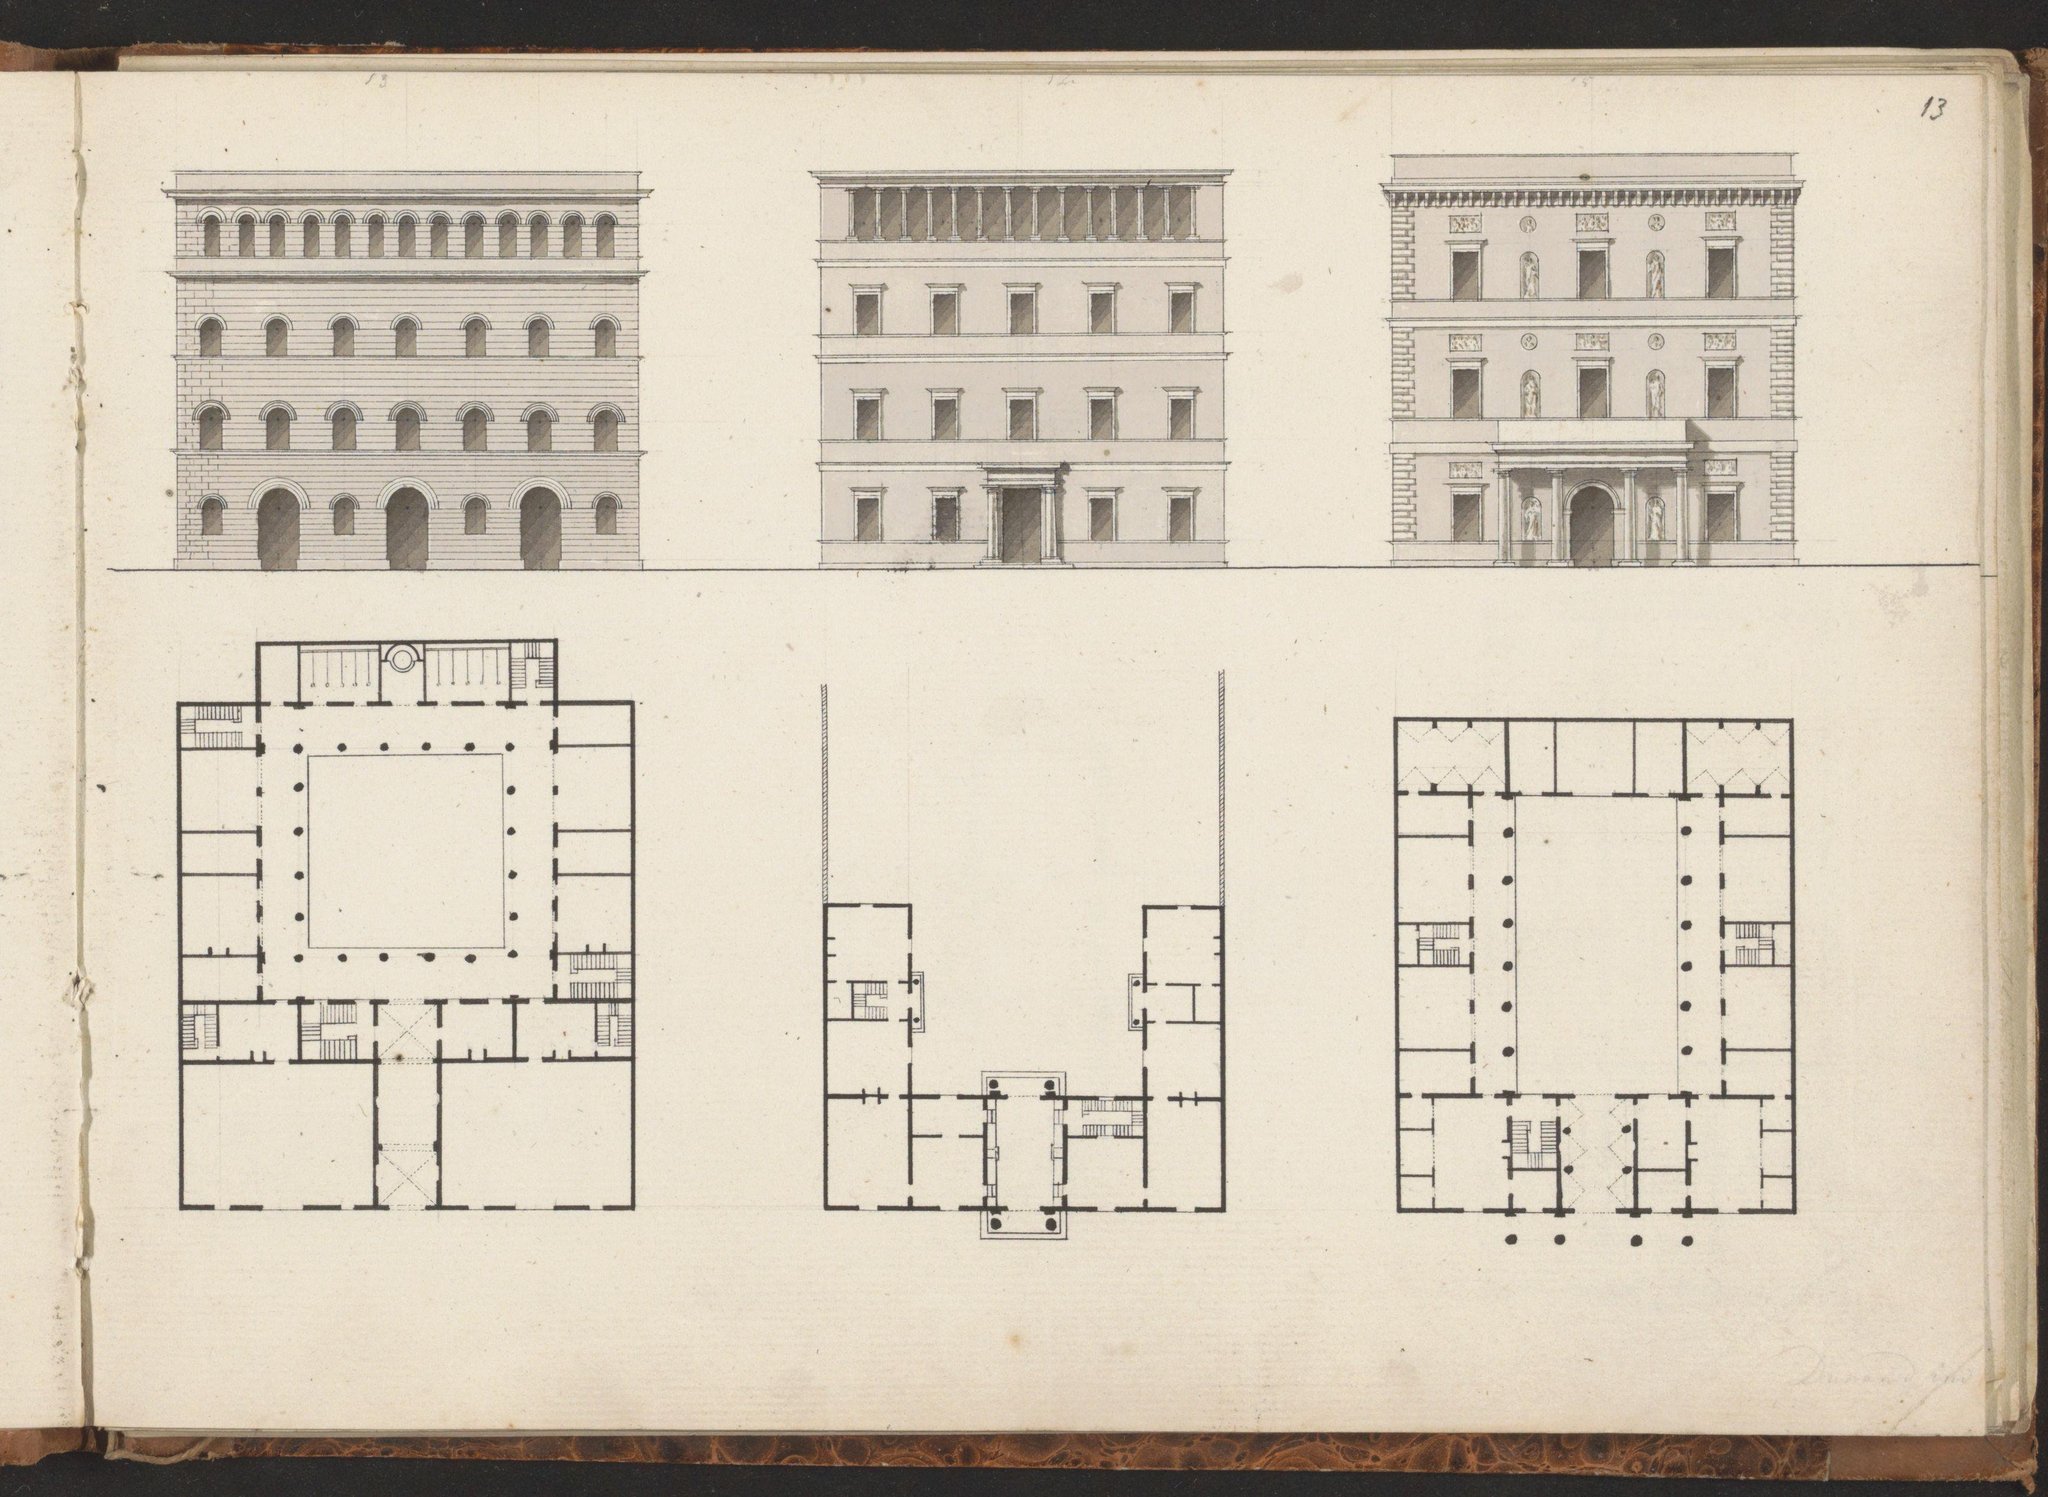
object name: sketchbook leaf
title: Plattegronden en voorgevels van drie villa's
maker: willem springer jr.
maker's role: draughtsman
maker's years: 1815-1907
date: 1825-1907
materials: ink, paper, pencil, watercolor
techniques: brush, pen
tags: villa, façade (of house or building), plan ~ architecture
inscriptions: annotation: ‘Durand ind.’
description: Pagina 13 uit een schetsboek met 86 pagina's.